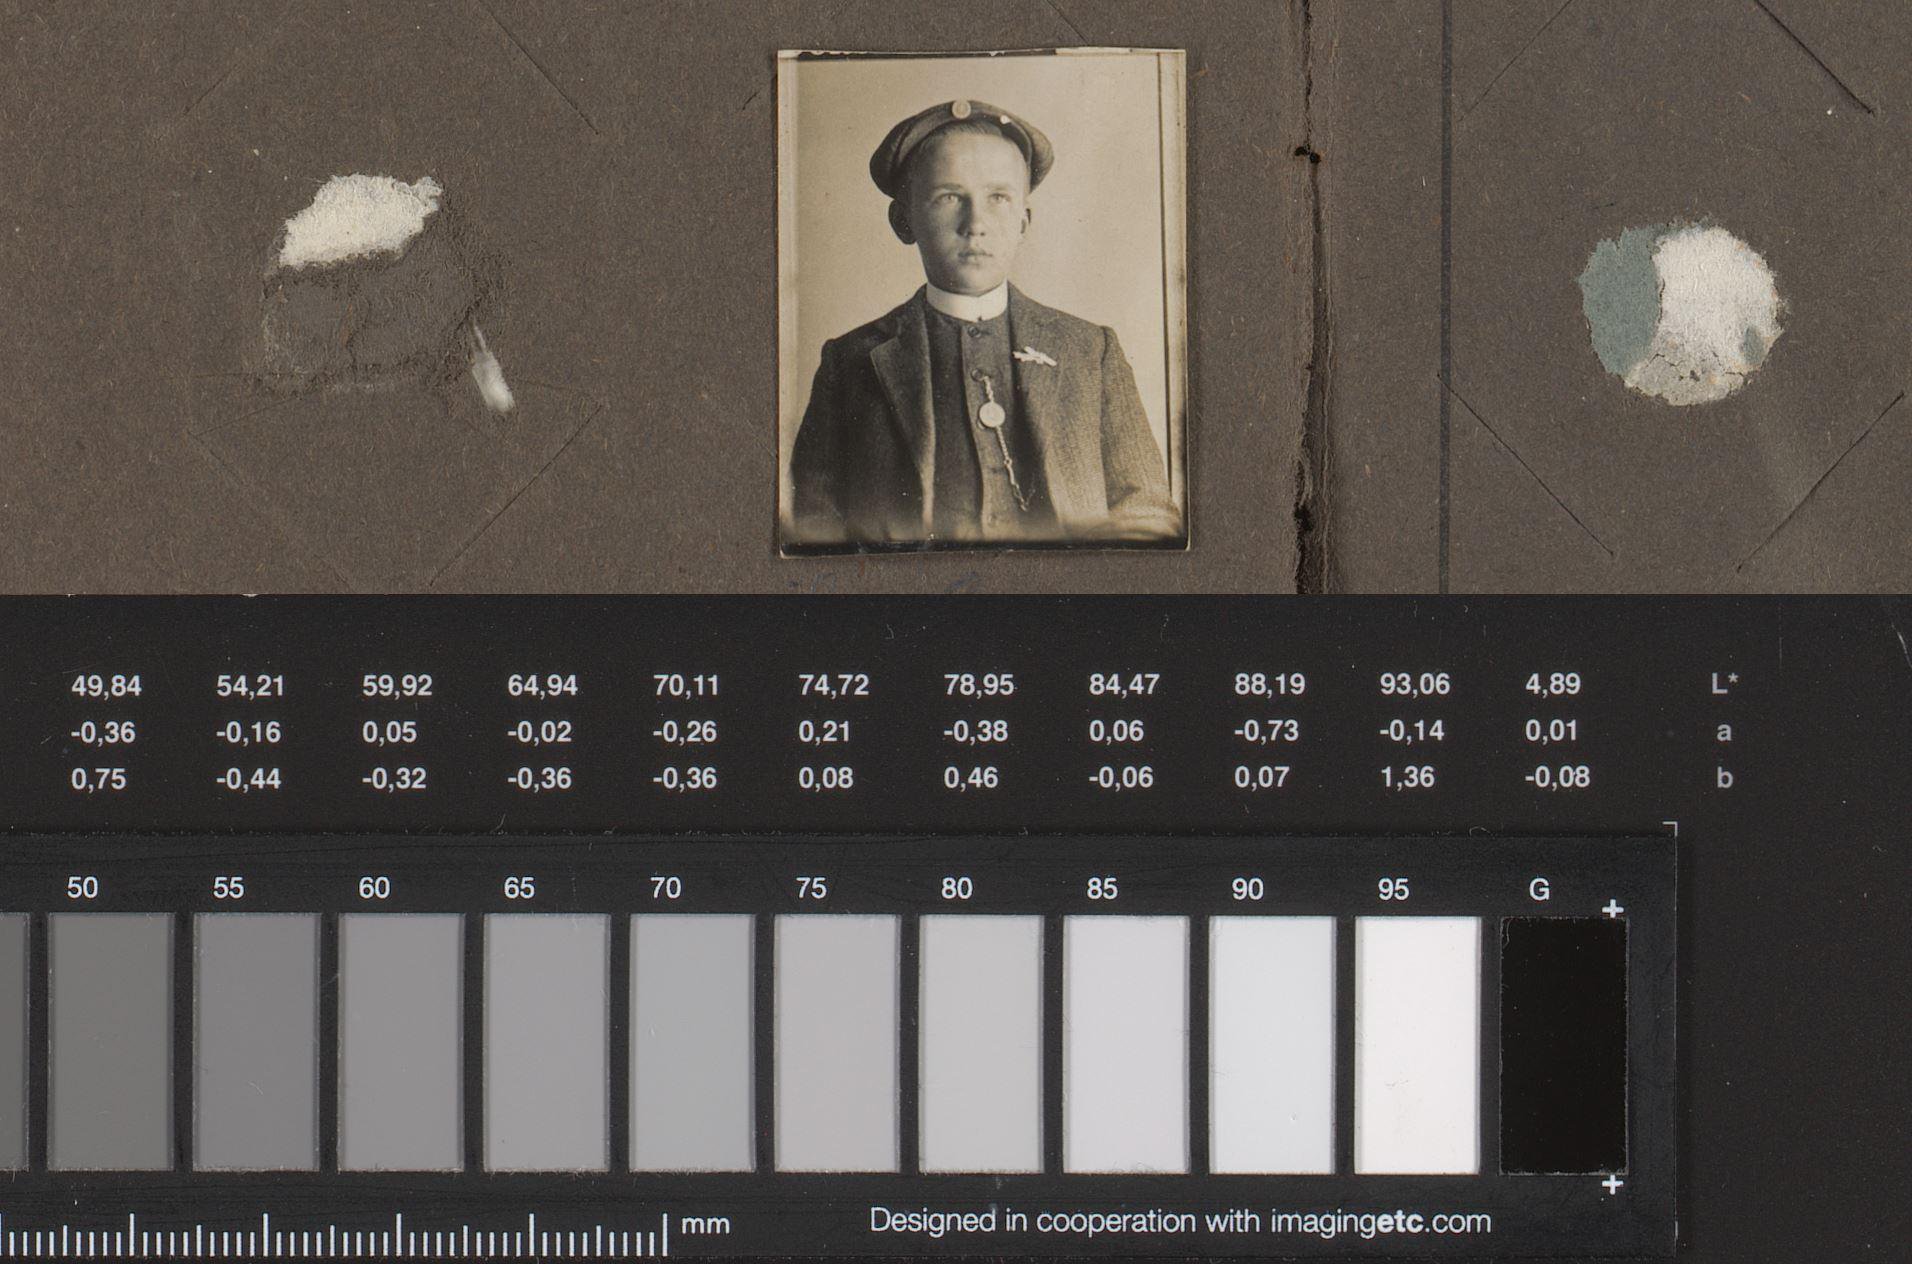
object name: album leaf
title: Portret van een onbekende jongen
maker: Anonymous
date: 1912-1916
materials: paper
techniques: gelatin silver print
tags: anonymous historical person portrayed